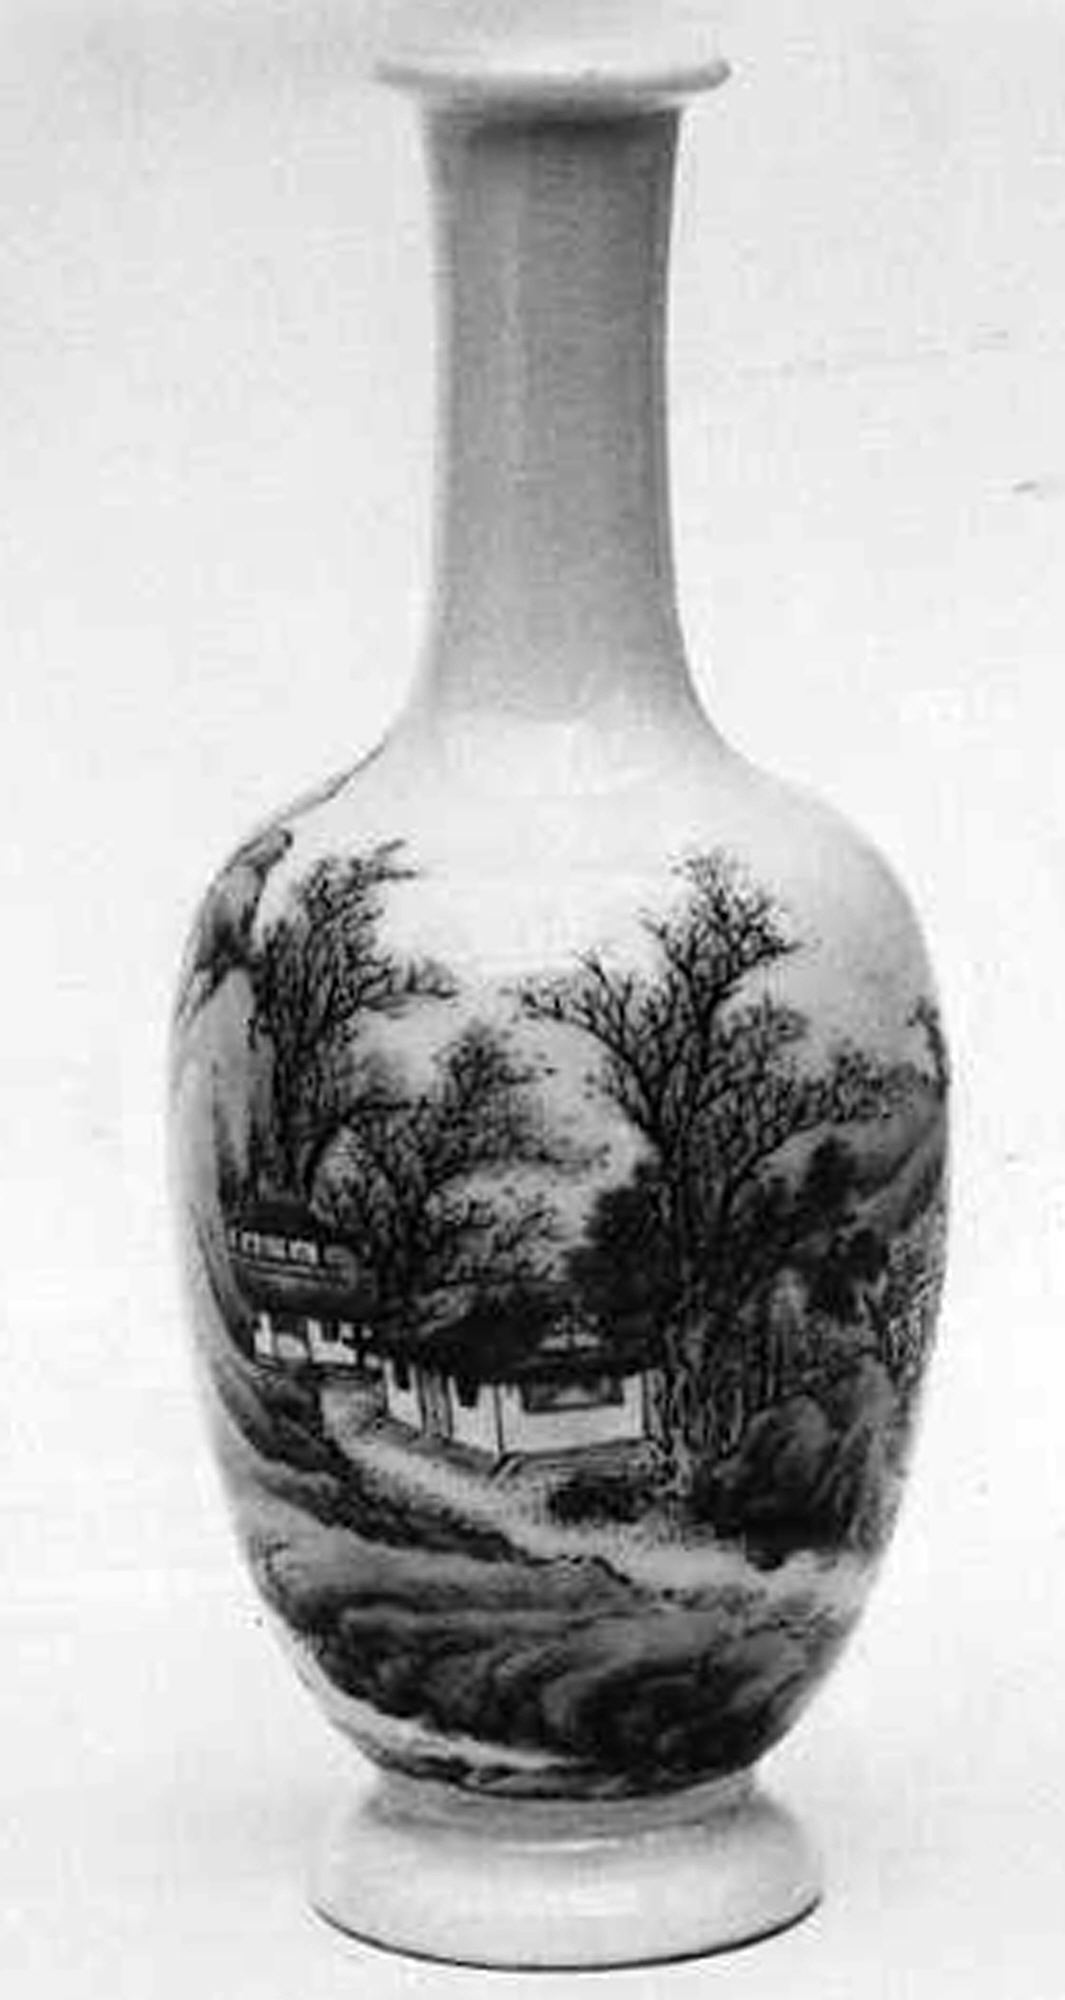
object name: vase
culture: chinese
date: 1736-1795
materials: porcelain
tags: houses,trees